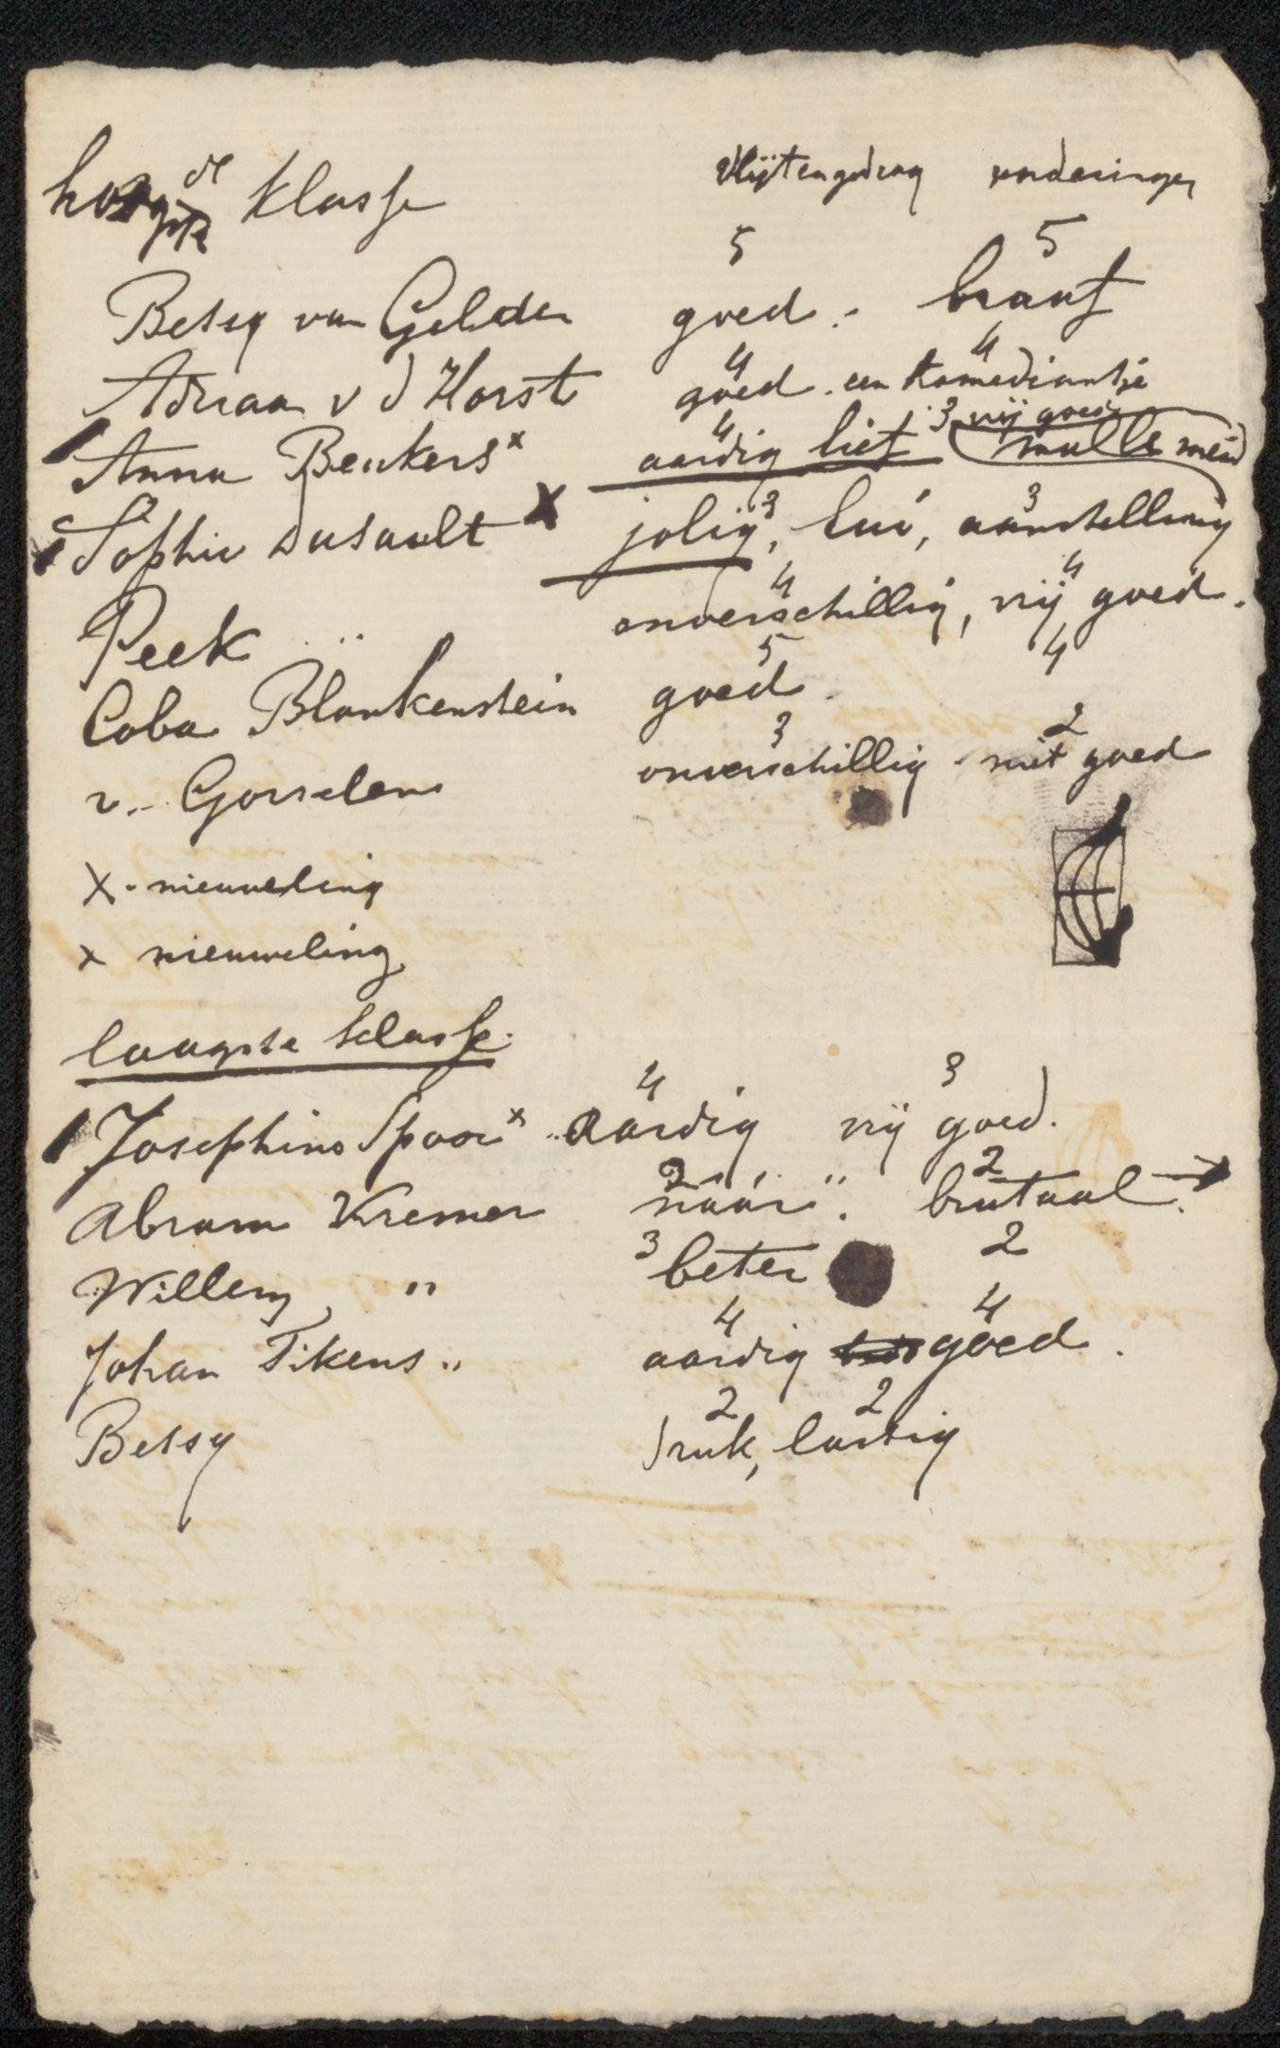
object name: aantekening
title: Aantekening uit archief Jan Veth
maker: jac van looij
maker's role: draughtsman, painter, print maker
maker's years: 1855-1930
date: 1865-1925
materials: ink, paper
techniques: pen, writing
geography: amsterdam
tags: dordrecht, painter, print maker, draughtsman, designer, jan veth, education, tuition of the artist (in general)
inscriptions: collector's mark: ‘RPK’